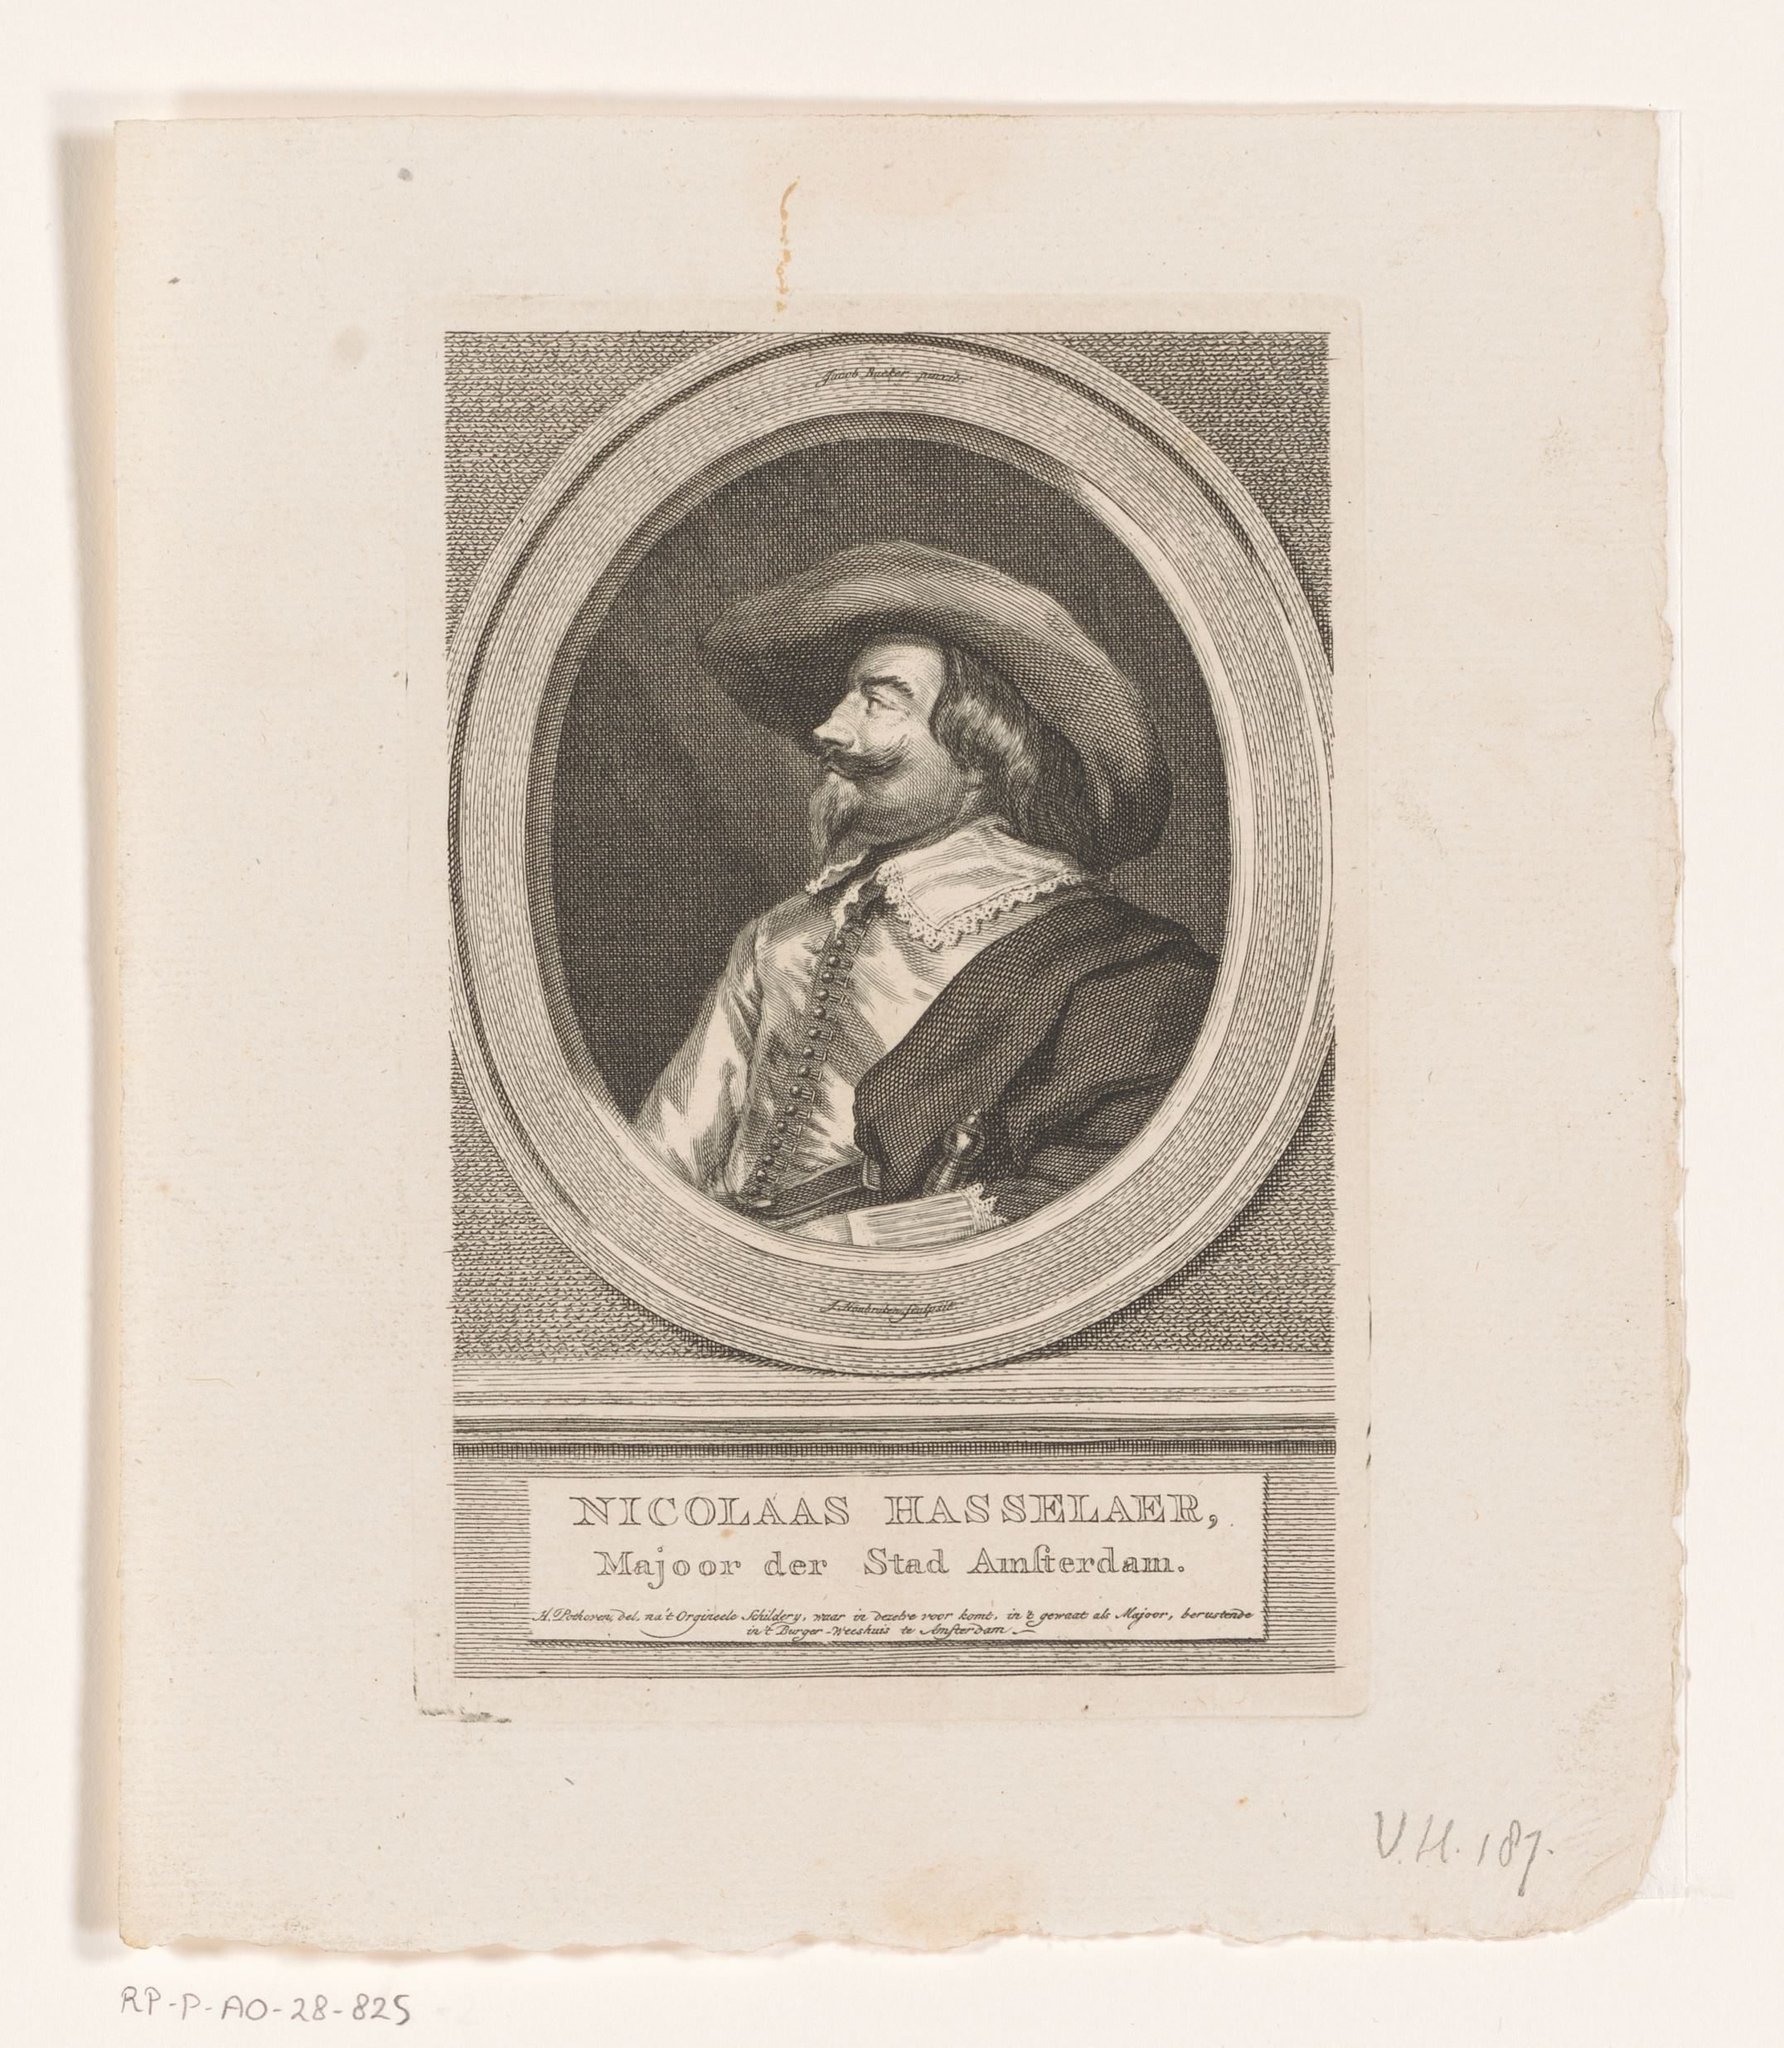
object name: print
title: Portret van Nikolaas Hasselaer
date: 1749-1780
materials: paper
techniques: engraving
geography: amsterdam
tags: historical persons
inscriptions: collector's mark: Lugt 2228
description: Deze prent is oorspronkelijk bedoeld als aanvulling op Jan Wagenaars ‘Vaderlandsche historie’* en was zo vanaf 1796 verkrijgbaar bij Johannes Allart te Amsterdam. Voor de advertentie waarin Allart de 60 portretten en 7 platen, allen gegraveerd door Houbraken, ter aanvulling op Wagenaars ‘Vaderlandsche historie’ aanbiedt, zie RP-P-OB-77.766. *Van dit werk zijn in de achttiende eeuw meerdere uitgaves verschenen, zoals: Wagenaar, Jan. Vaderlandsche historie, vervattende de geschiedenissen der Vereenigde Nederlanden (…). 21 delen. Amsterdam: Isaak Tirion, 1749-1759. Wagenaar, Jan. Vaderlandsche historie, vervattende de geschiedenissen der nu Vereenigde Nederlanden (…). 21 delen. Amsterdam: weduwe Isaak Tirion, 1770. Wagenaar, Jan. Vaderlandsche historie, vervattende de geschiedenissen der nu Vereenigde Nederlanden (…). 21 delen. Amsterdam, Leiden, Dordrecht en Harlingen: P. Schouten e.a., 1782. Wagenaar, Jan. Vaderlandsche historie, vervattende de geschiedenissen der nu Vereenigde Nederlanden (…). 21 delen. Amsterdam: Johannes Allart, 1790-1796.